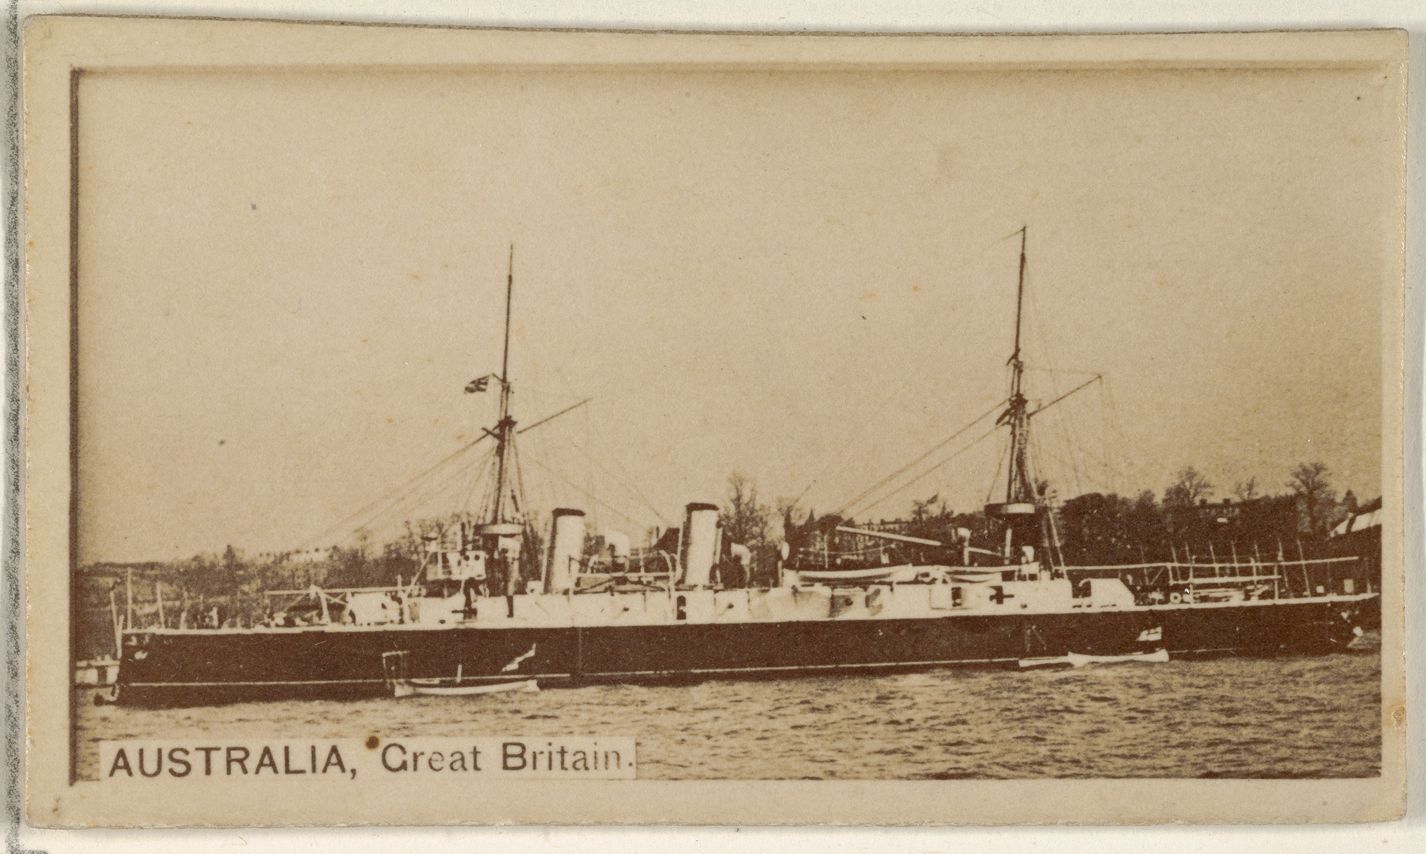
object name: photograph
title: Australia, Great Britain, from the Famous Ships series (N50) for Virginia Brights Cigarettes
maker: allen & ginter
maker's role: publisher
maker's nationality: american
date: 1895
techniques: albumen silver print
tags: ships